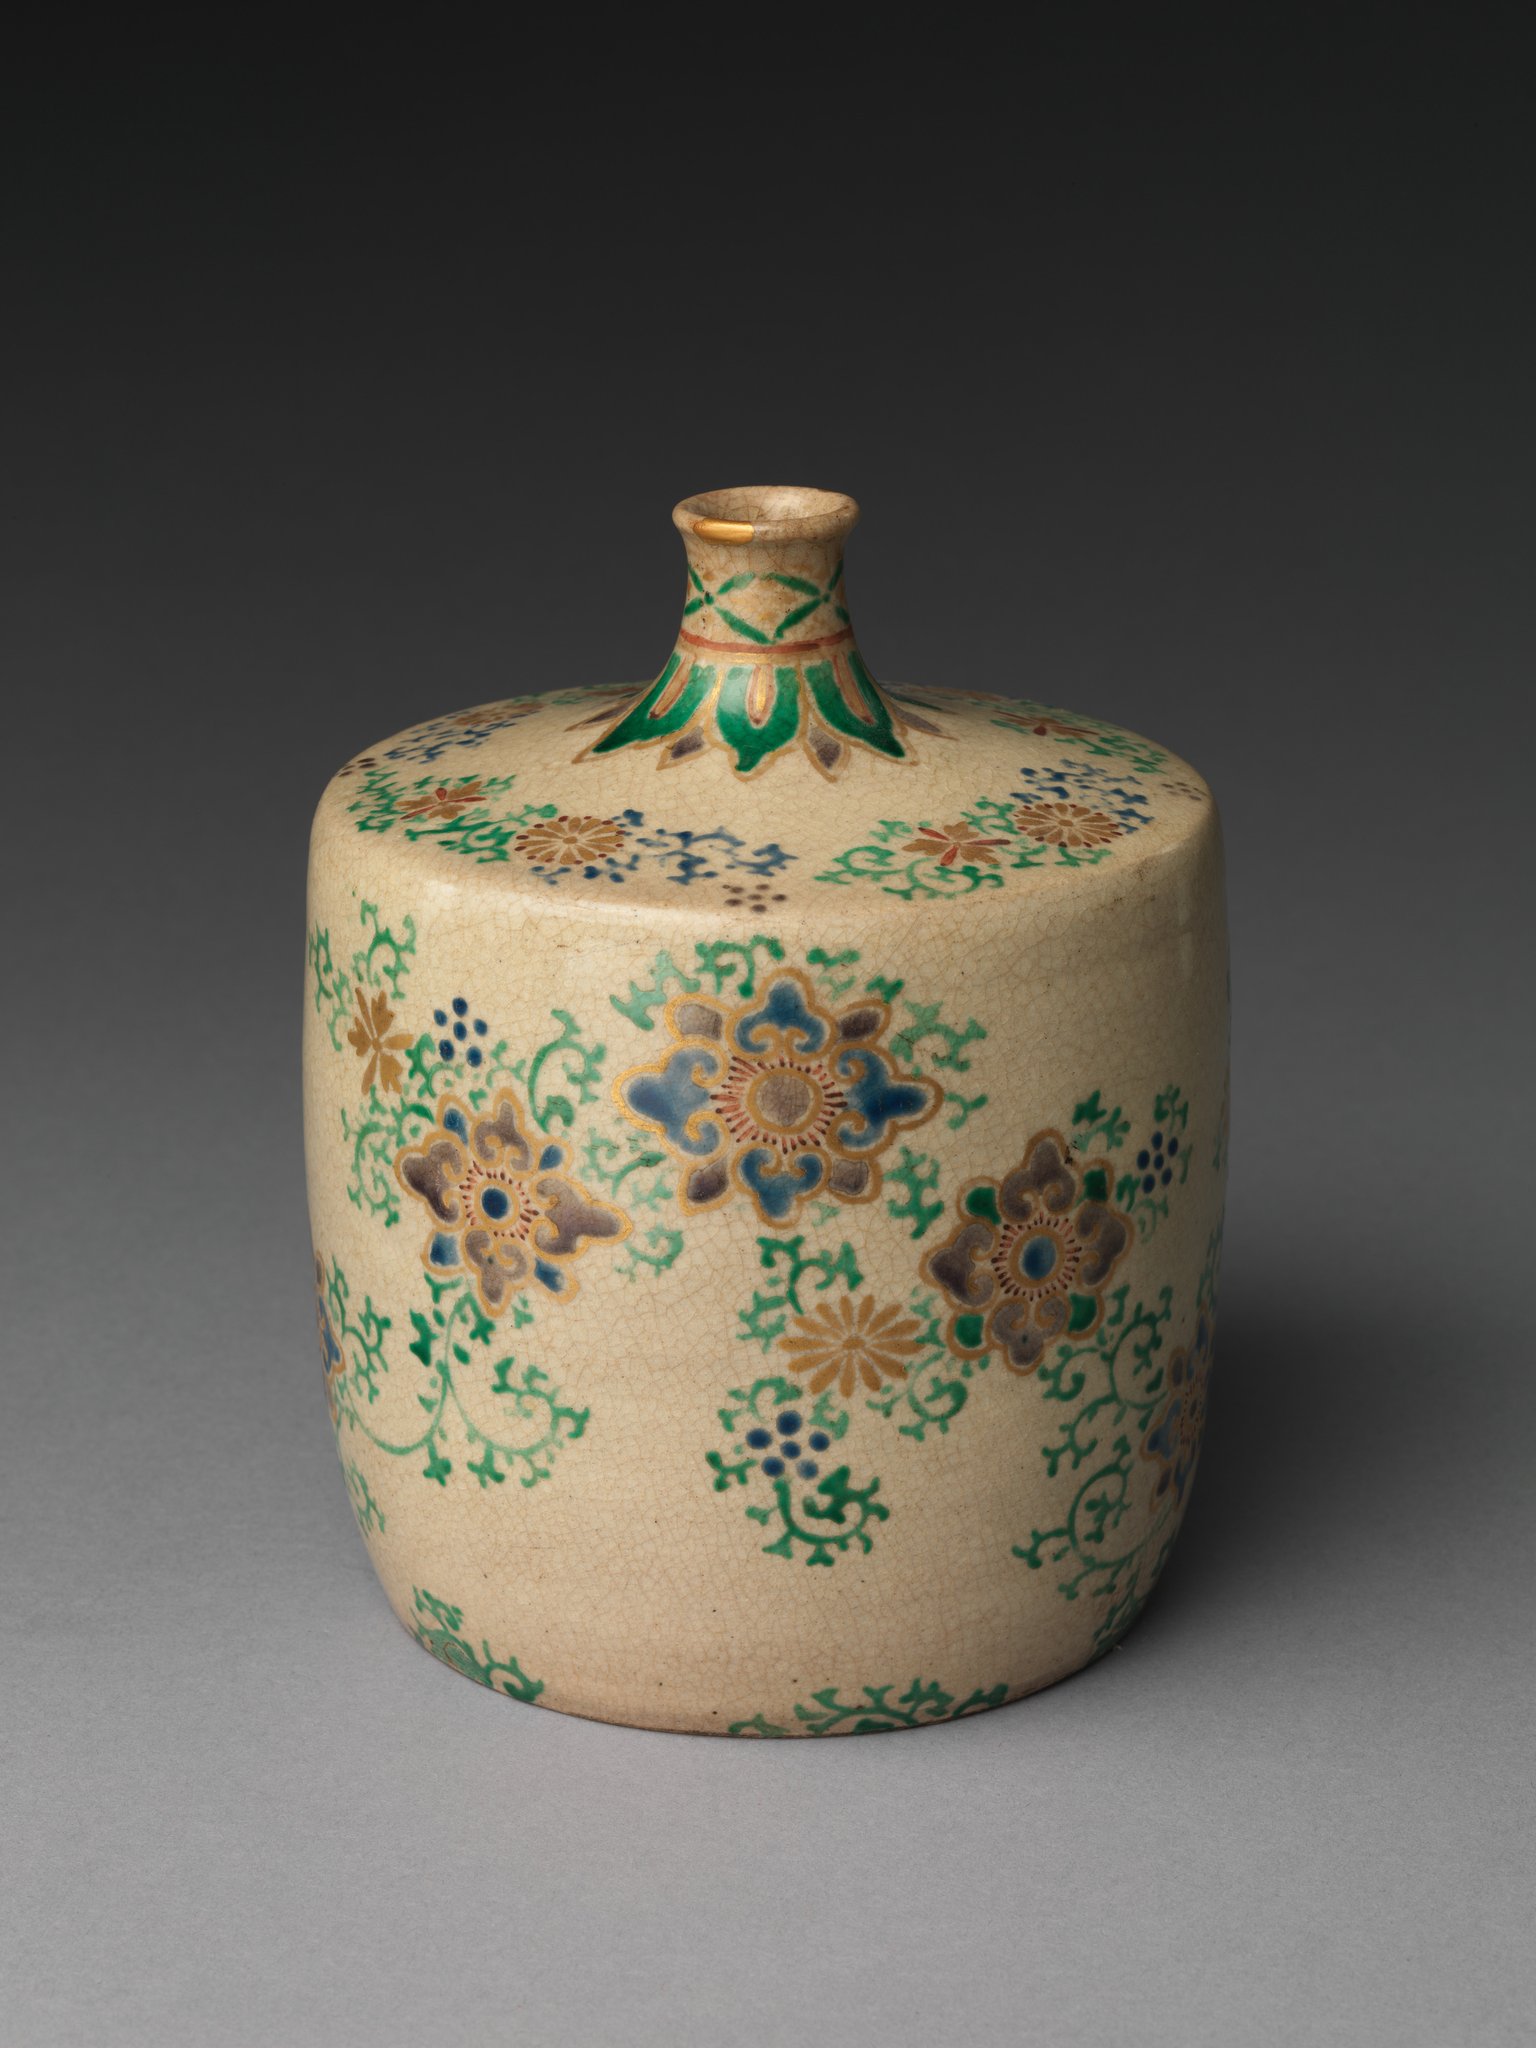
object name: vase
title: Sake bottle (Tokkuri)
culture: japanese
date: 1700-1750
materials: stoneware